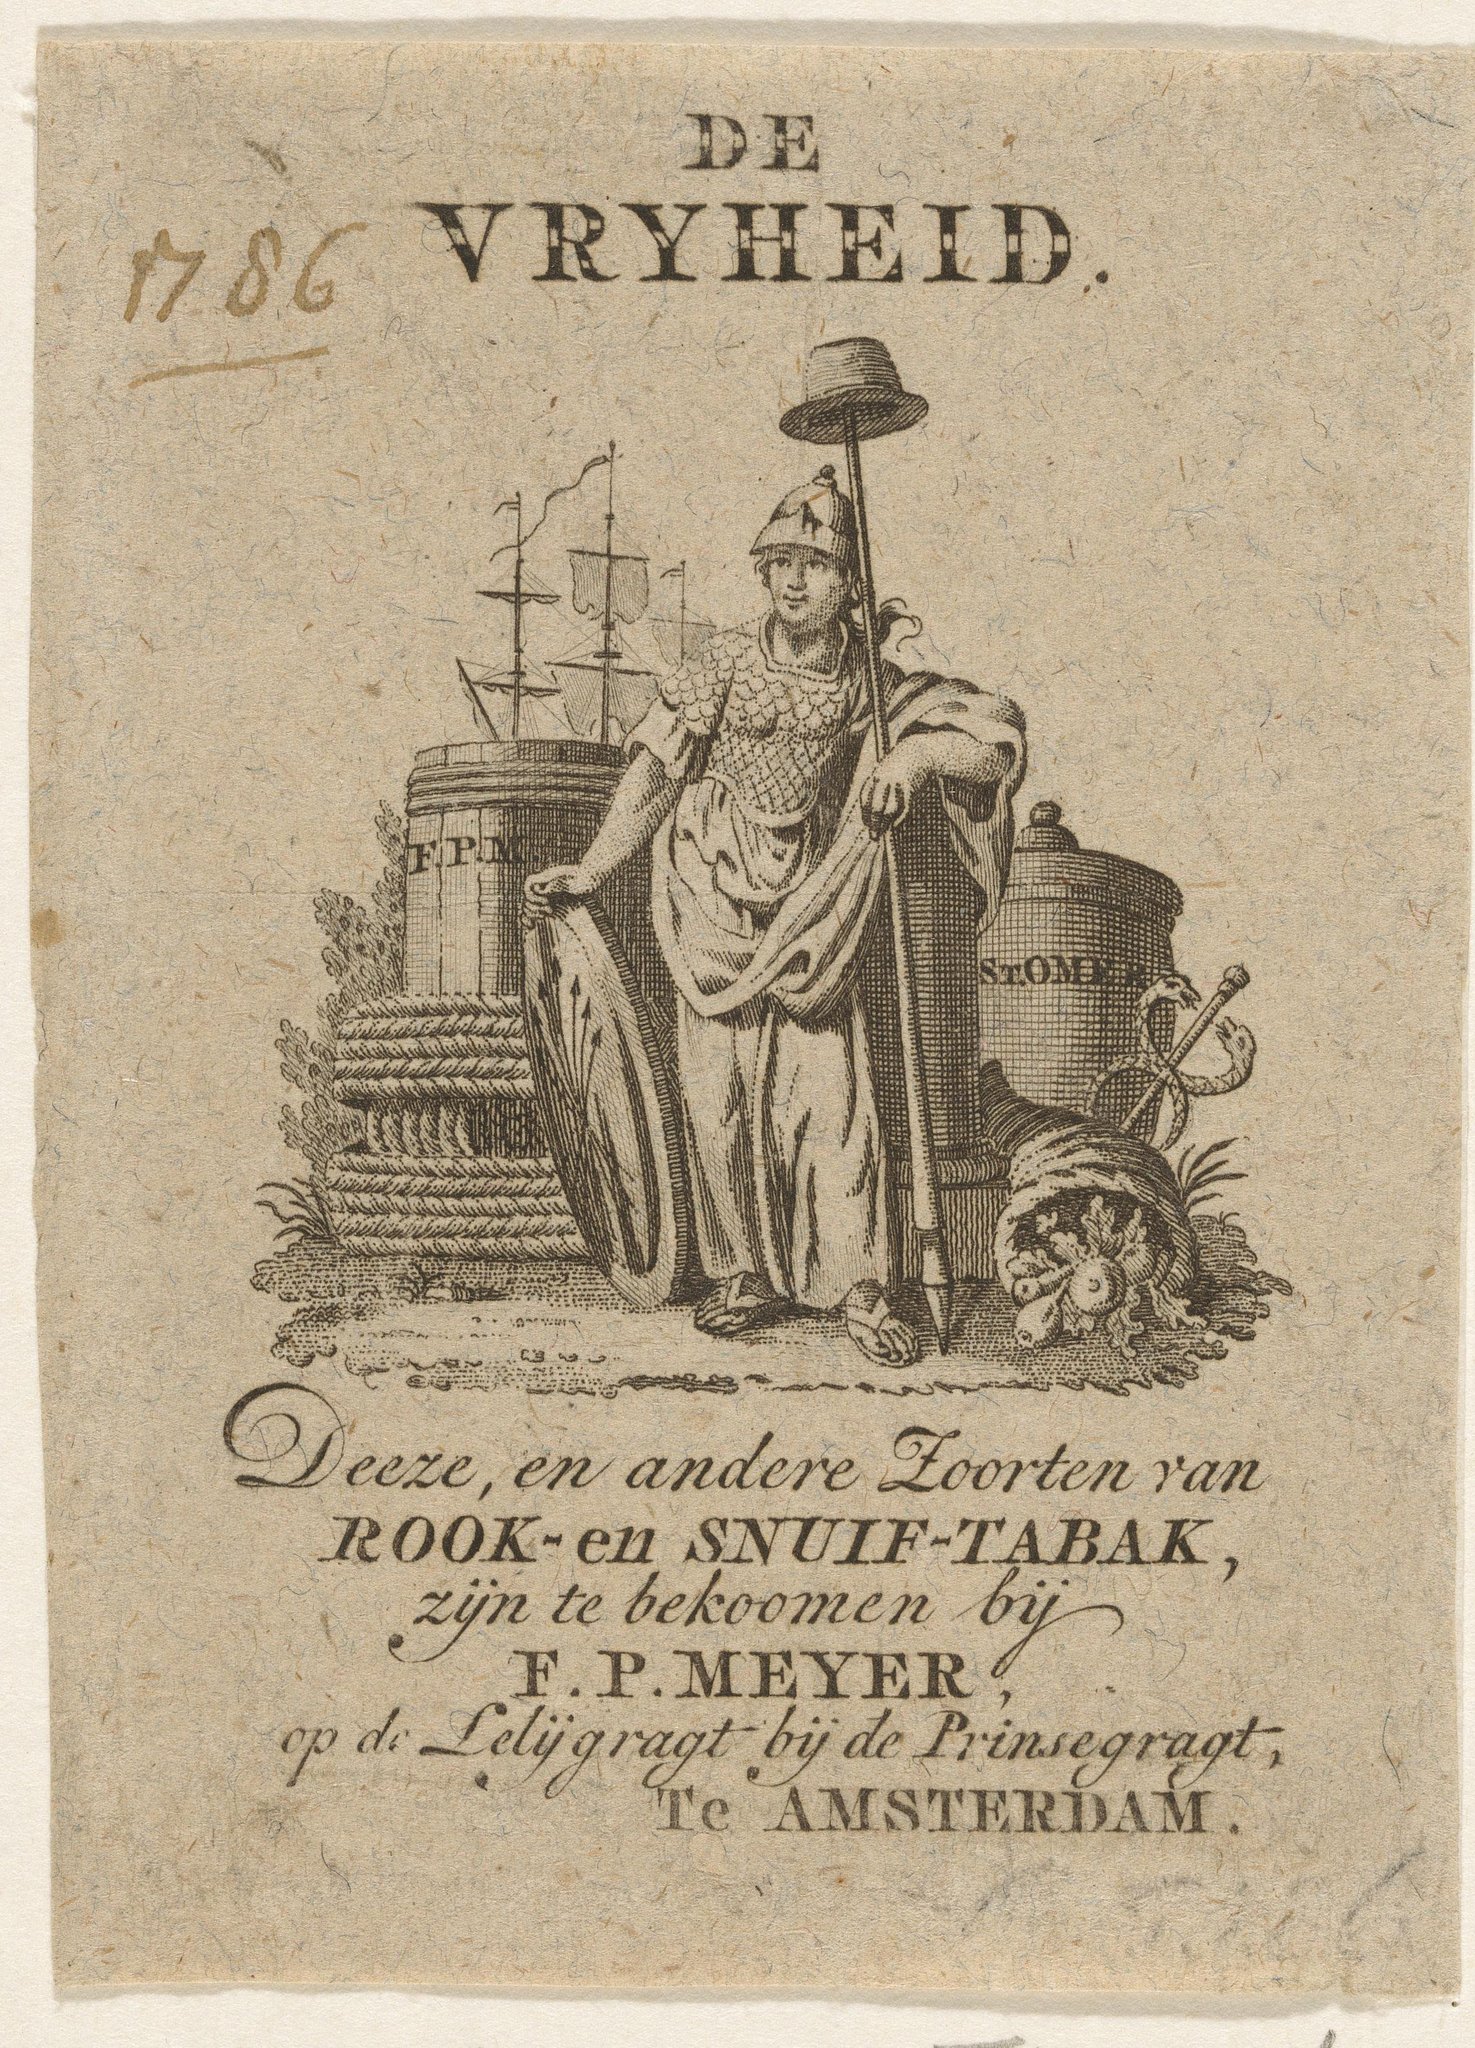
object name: print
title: Vignet van de tabakshandelaar F.P. Meyer te Amsterdam, ca. 1787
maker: Anonymous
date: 1787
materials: paper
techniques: engraving, etching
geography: northern netherlands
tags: freedom, liberty; 'libertà' (ripa) (+ abstract concept represented by female figure), patriots (1780-1795)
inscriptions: collector's mark: Lugt 2228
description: Handelsetiket van de tabakshandelaar F.P. Meyer op de Leliegracht te Amsterdam, ca. 1787. De vrijheid staande naast een kolom waarop St. Omer staat. Mogelijk in verband met het vluchten van de patriotten naar Sint-Omaars in Frankrijk, na het herstel van de prins van Oranje in 1787.